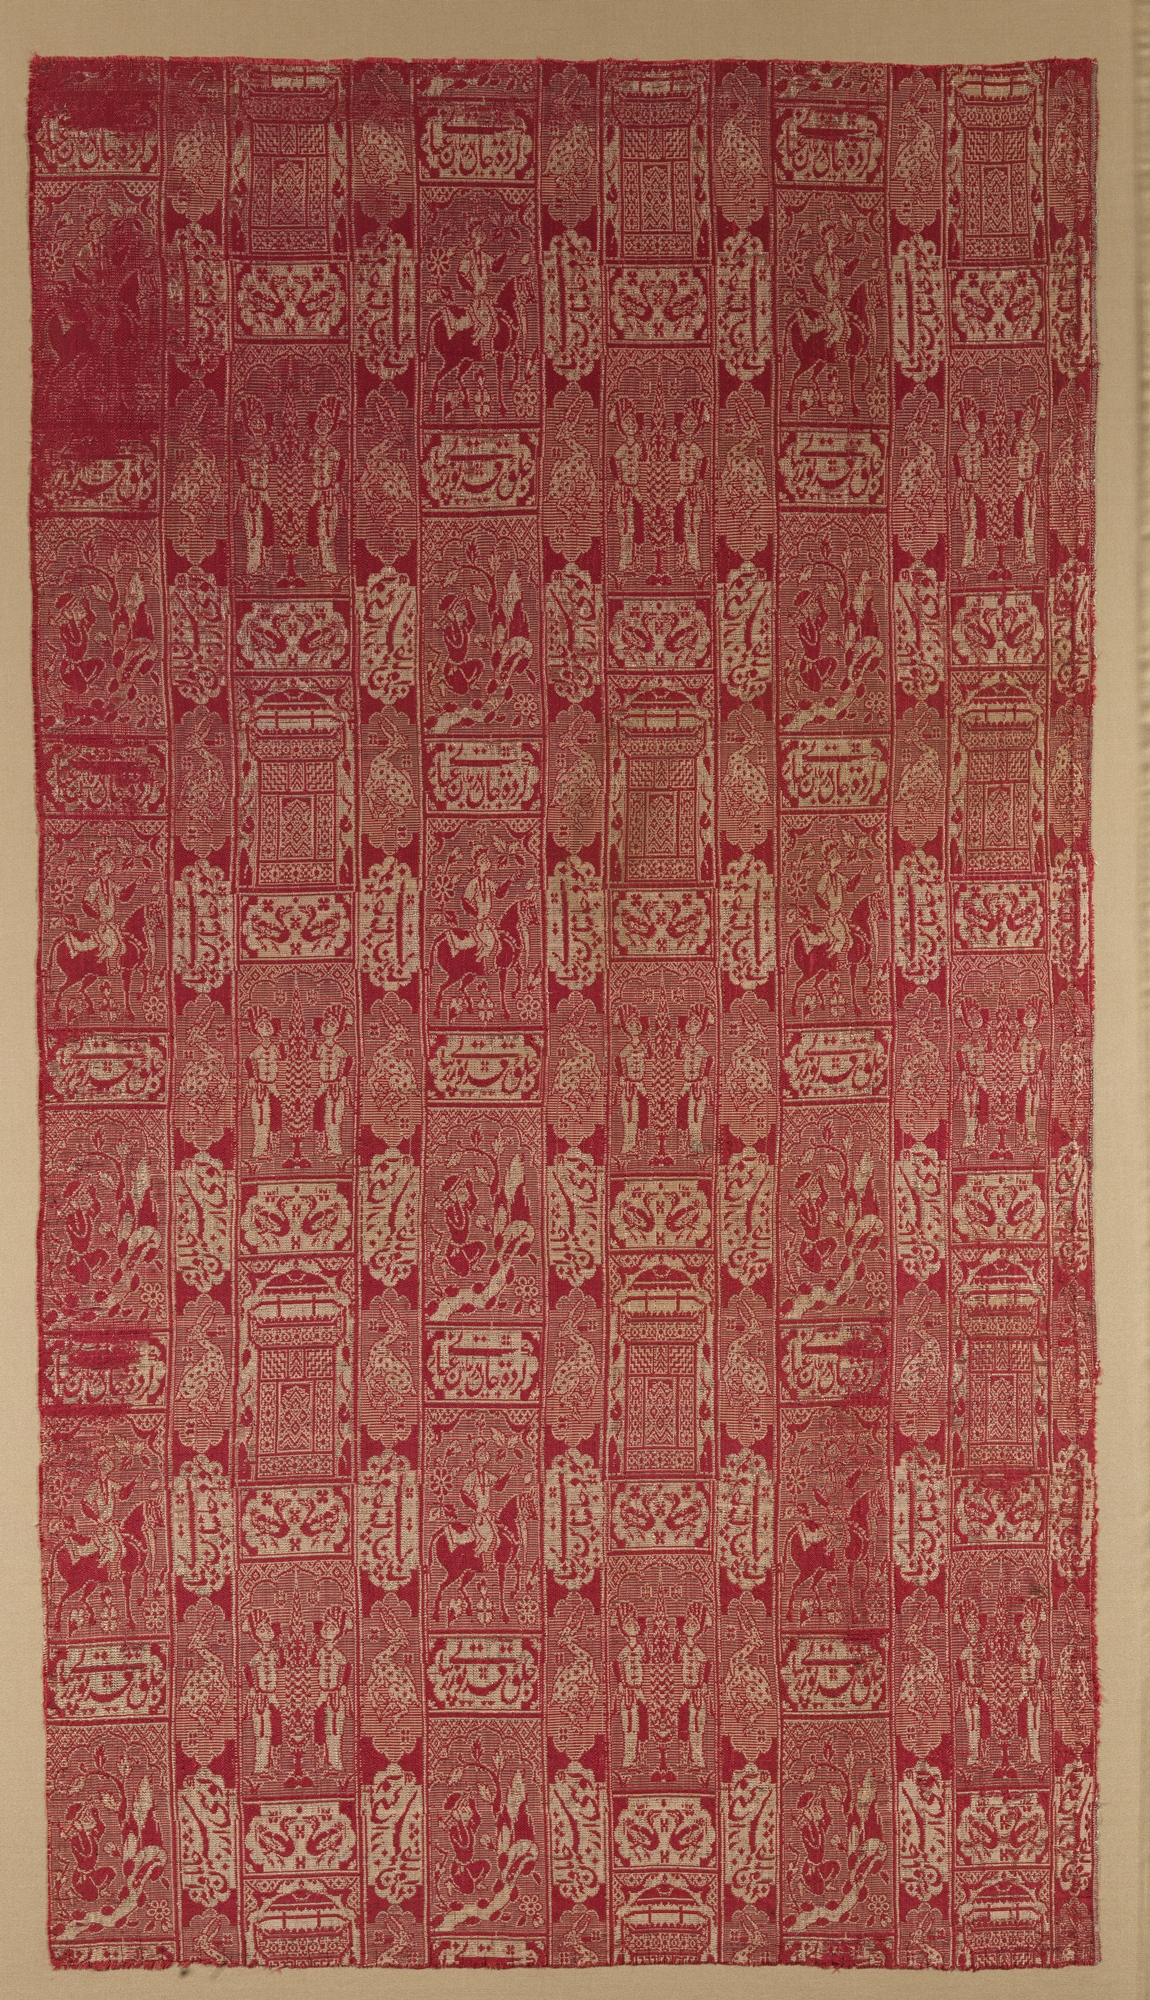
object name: panel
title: Textile Depicting a Scene from Nizami's Khamsa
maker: nizami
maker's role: author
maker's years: 1141-1209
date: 1501-1700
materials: metal thread, silk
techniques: weave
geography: iran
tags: human figures,animals,horses